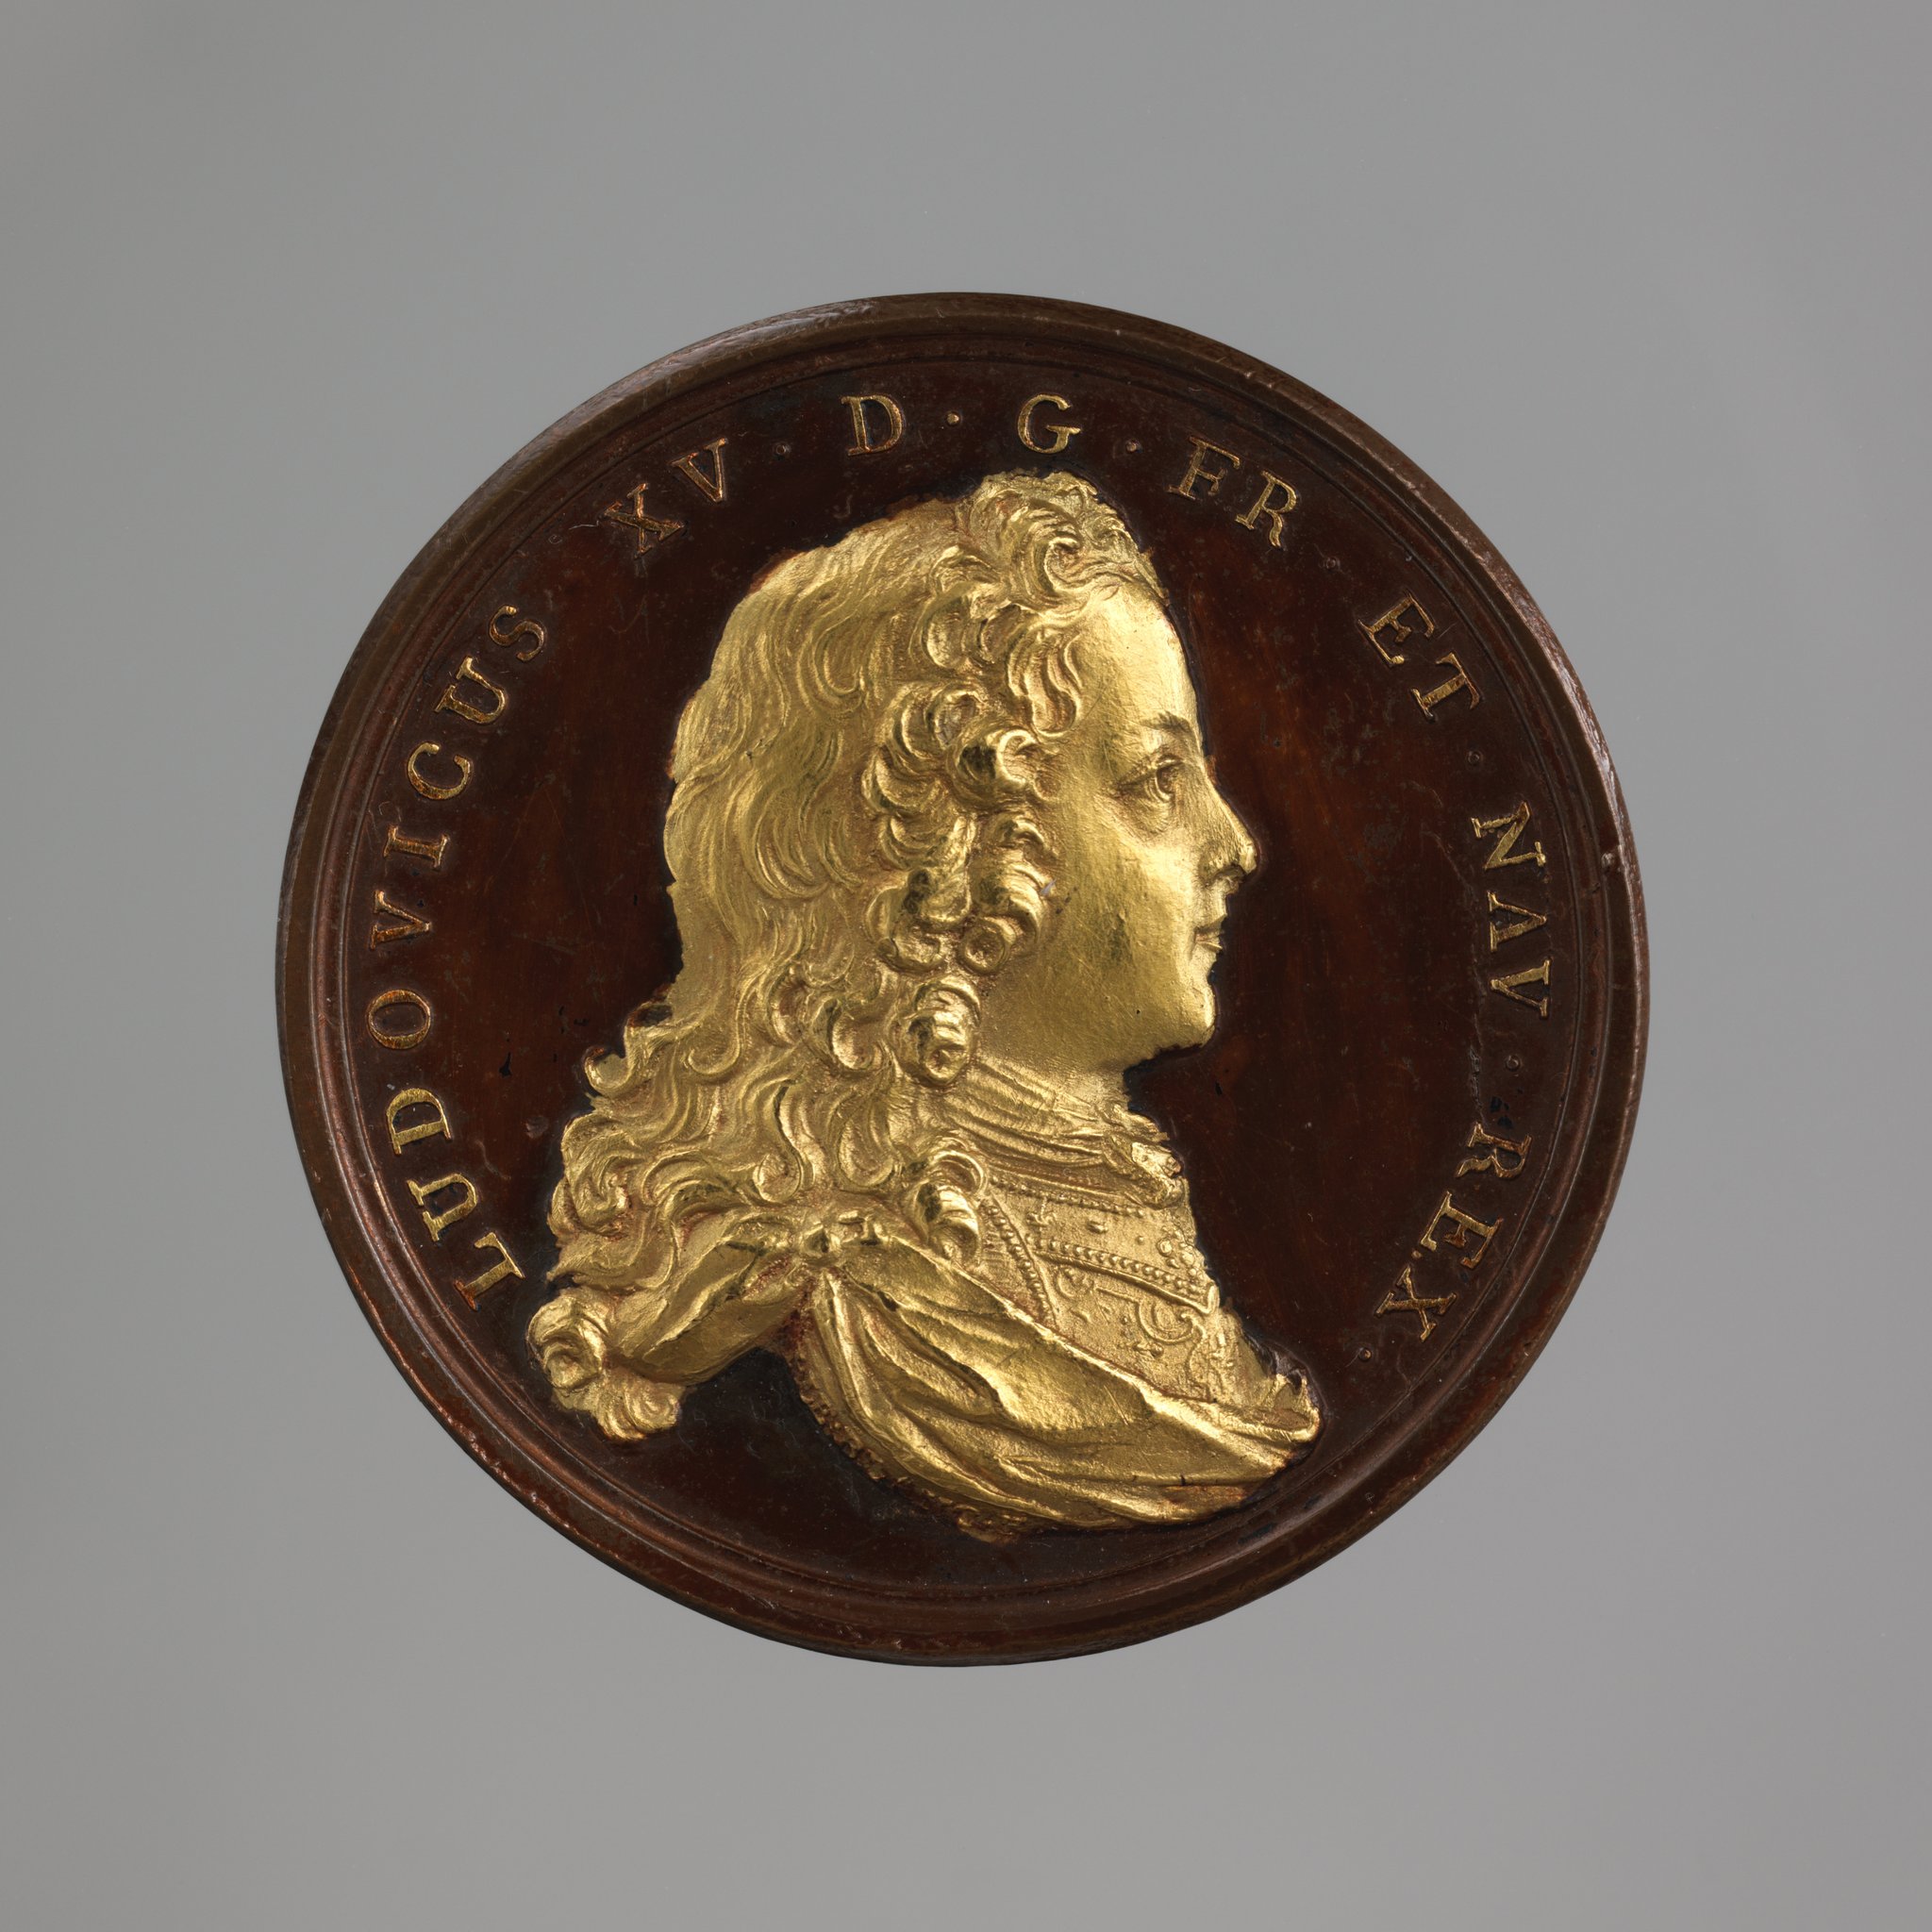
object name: medal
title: Louis XV: Education of the King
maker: jean le blanc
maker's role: artist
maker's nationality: french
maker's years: 1676-1749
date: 1717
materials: gilt bronze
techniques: lacquer